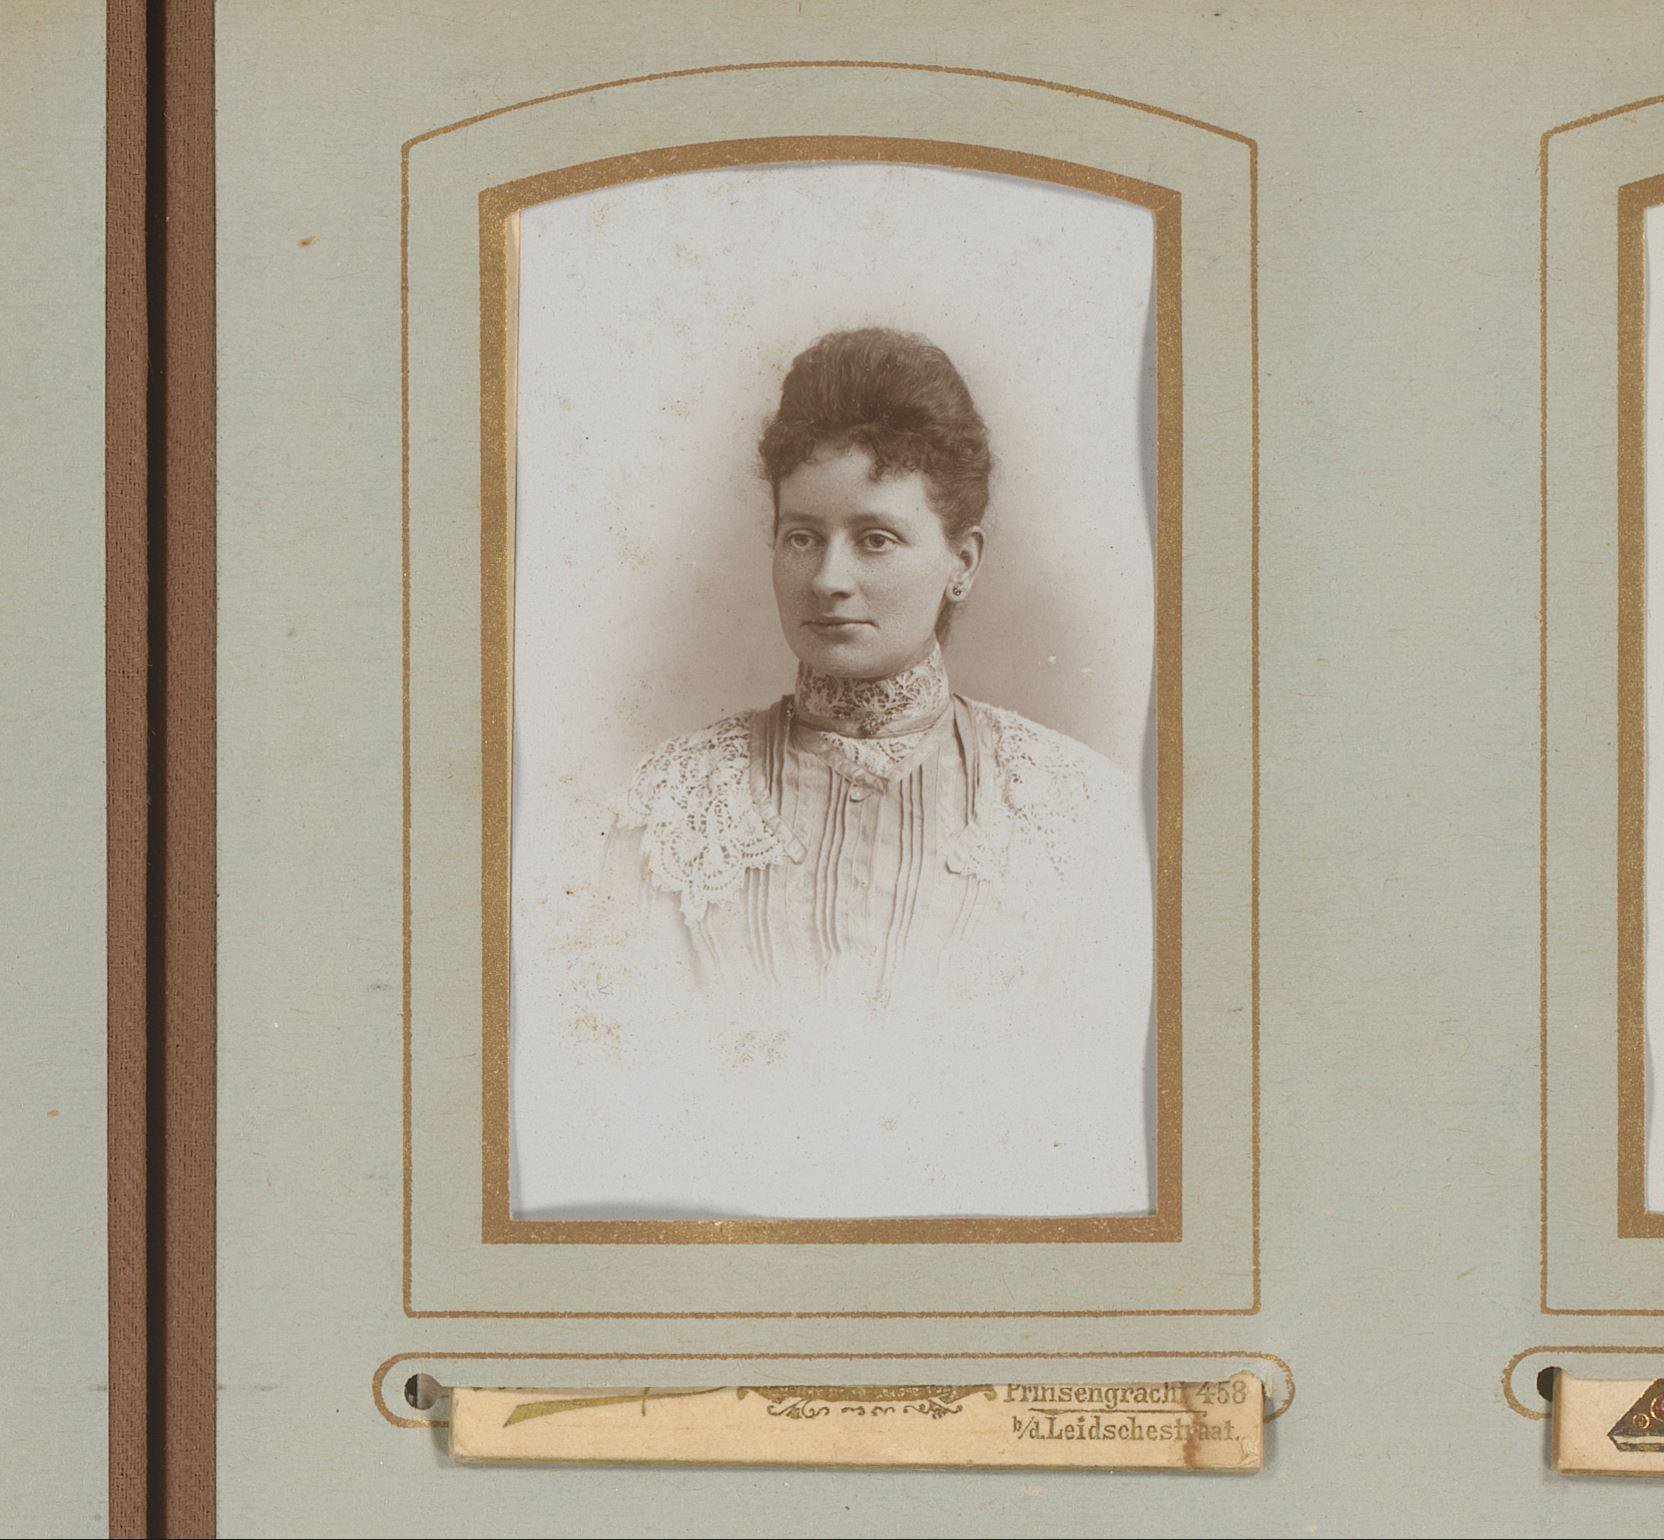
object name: album leaf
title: Portret van een vrouw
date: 1892-1910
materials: cardboard, photographic support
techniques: collodion silver print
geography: amsterdam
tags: historical persons - bb - woman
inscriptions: number: ‘6385’, inscription: ‘Atelier Herz/ Amsterdam/ Prinsengracht 458/ b./d. Leidschestraat’